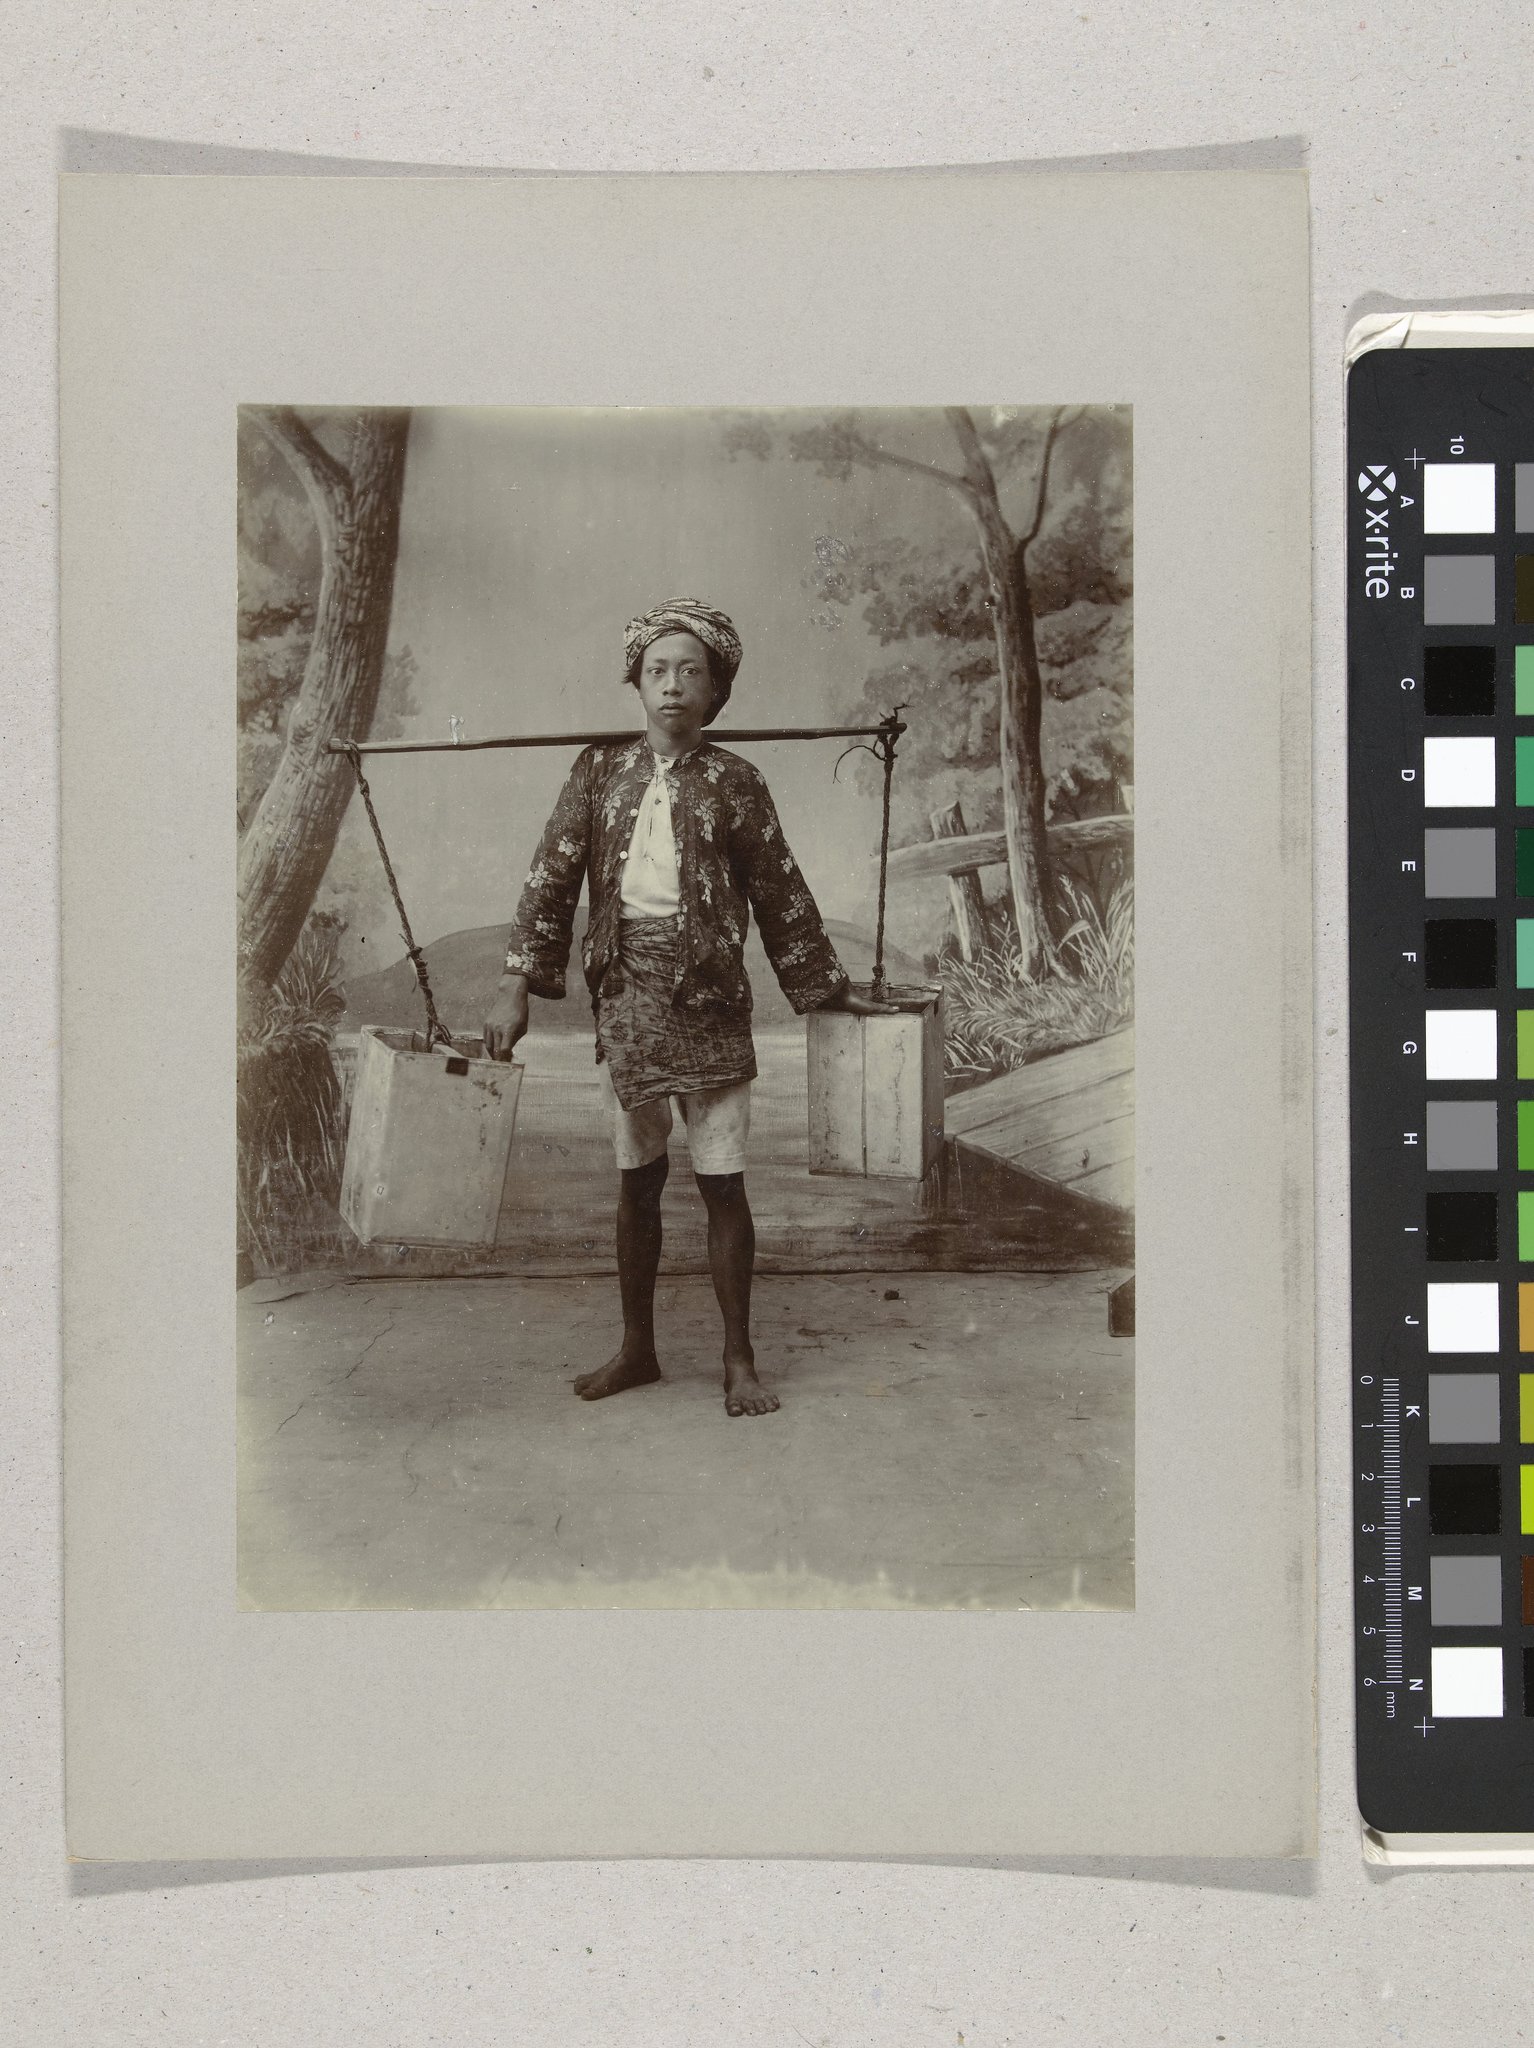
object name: photograph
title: Studioportret van een jongeman met een juk met twee blikken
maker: Anonymous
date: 1895-1915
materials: cardboard, paper, photographic support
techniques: gelatin silver print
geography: dutch east indies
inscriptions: number: ‘14’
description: Jongeman met een juk en twee blikken voor een geschilderd decor, Nederlands-Indië